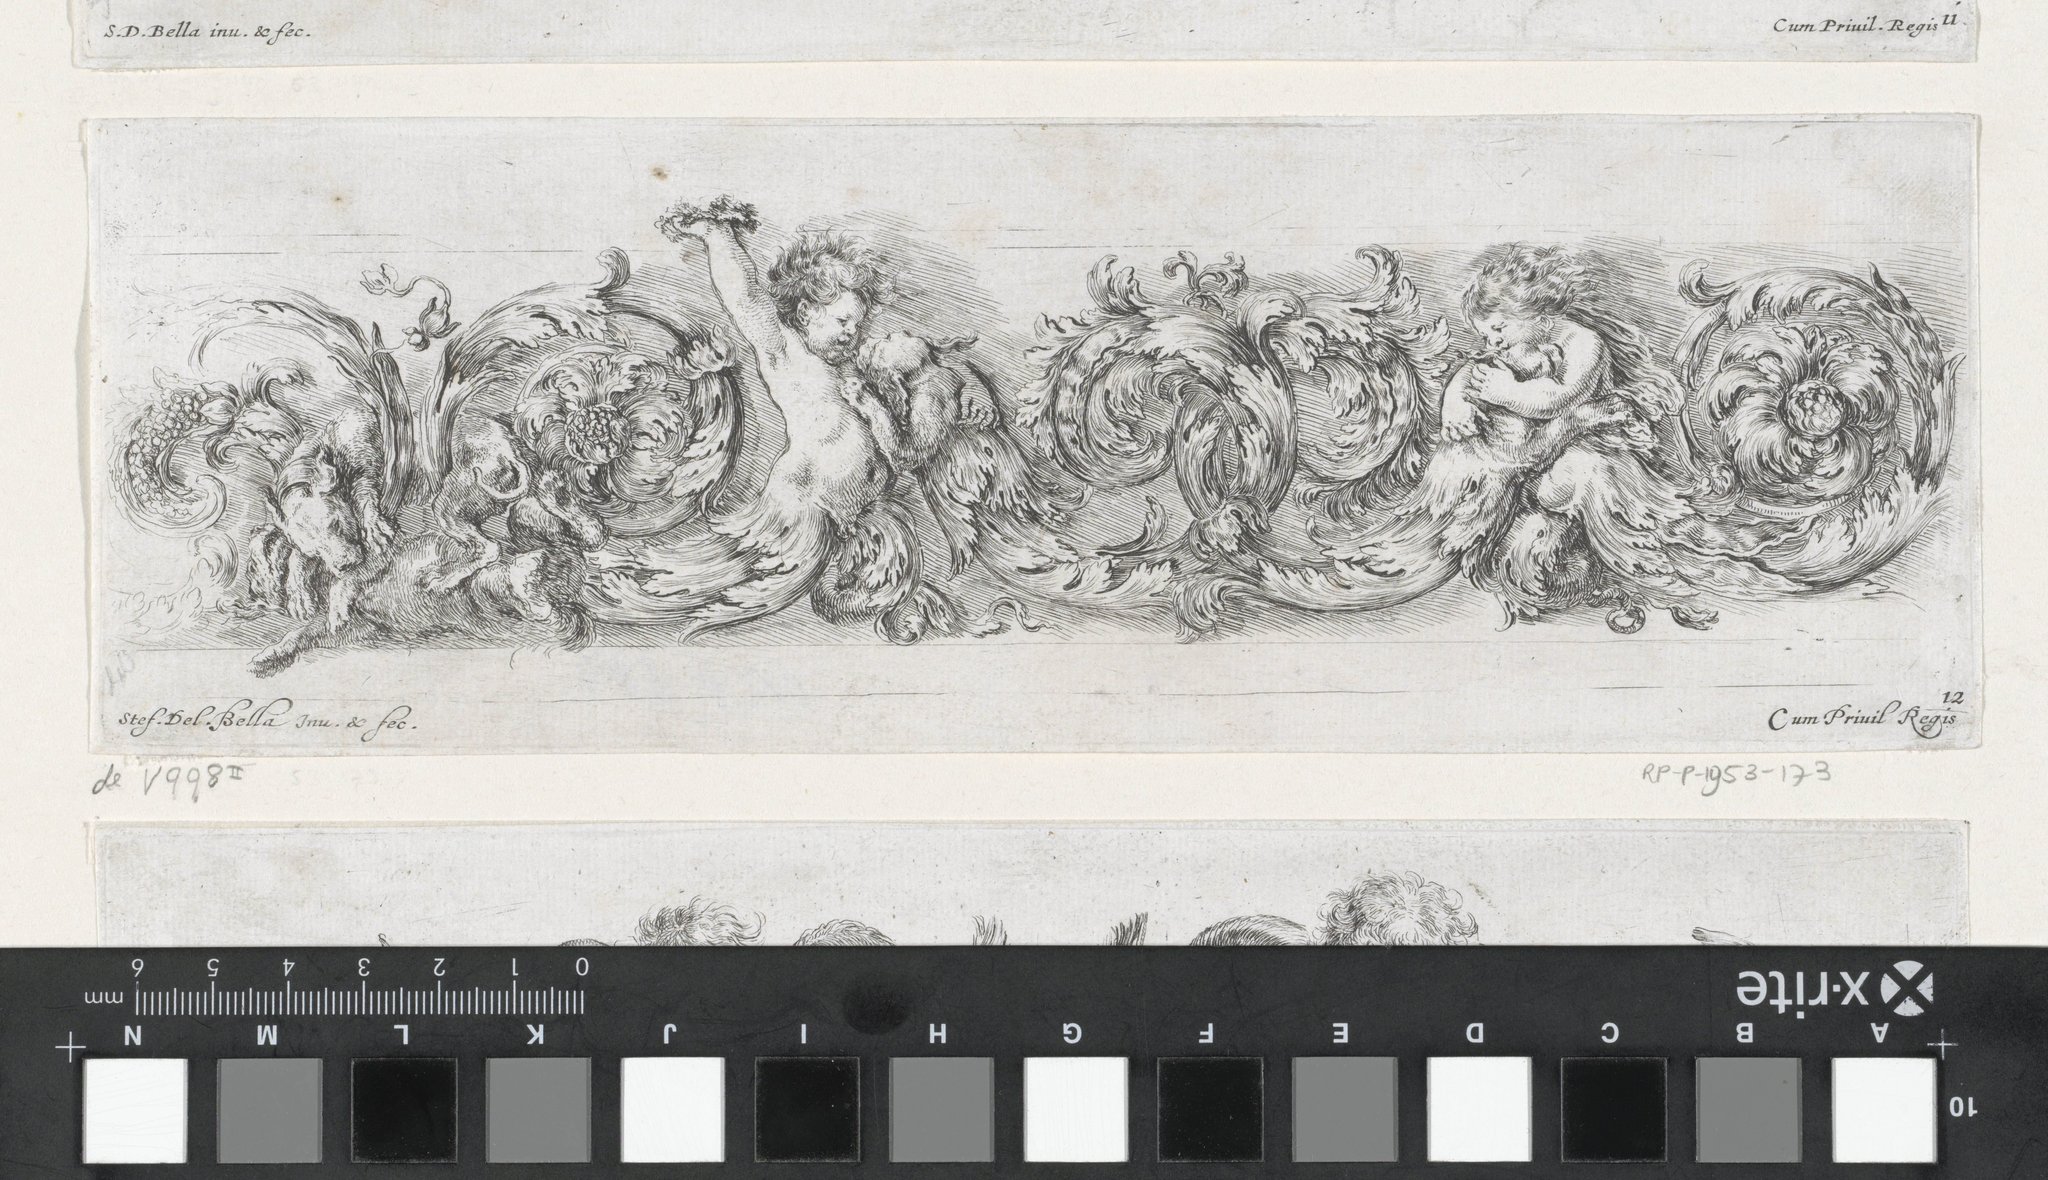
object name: ornament print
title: Ornamenti di fregi et fogliani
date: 1620-1664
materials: paper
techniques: etching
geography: paris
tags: foliage ~ ornament, child, child playing with animals, dog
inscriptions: collector's mark: Lugt 2228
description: Een fries met twee kinderen die met honden spelen. De kinderen en de honden lopen over in bladornament.